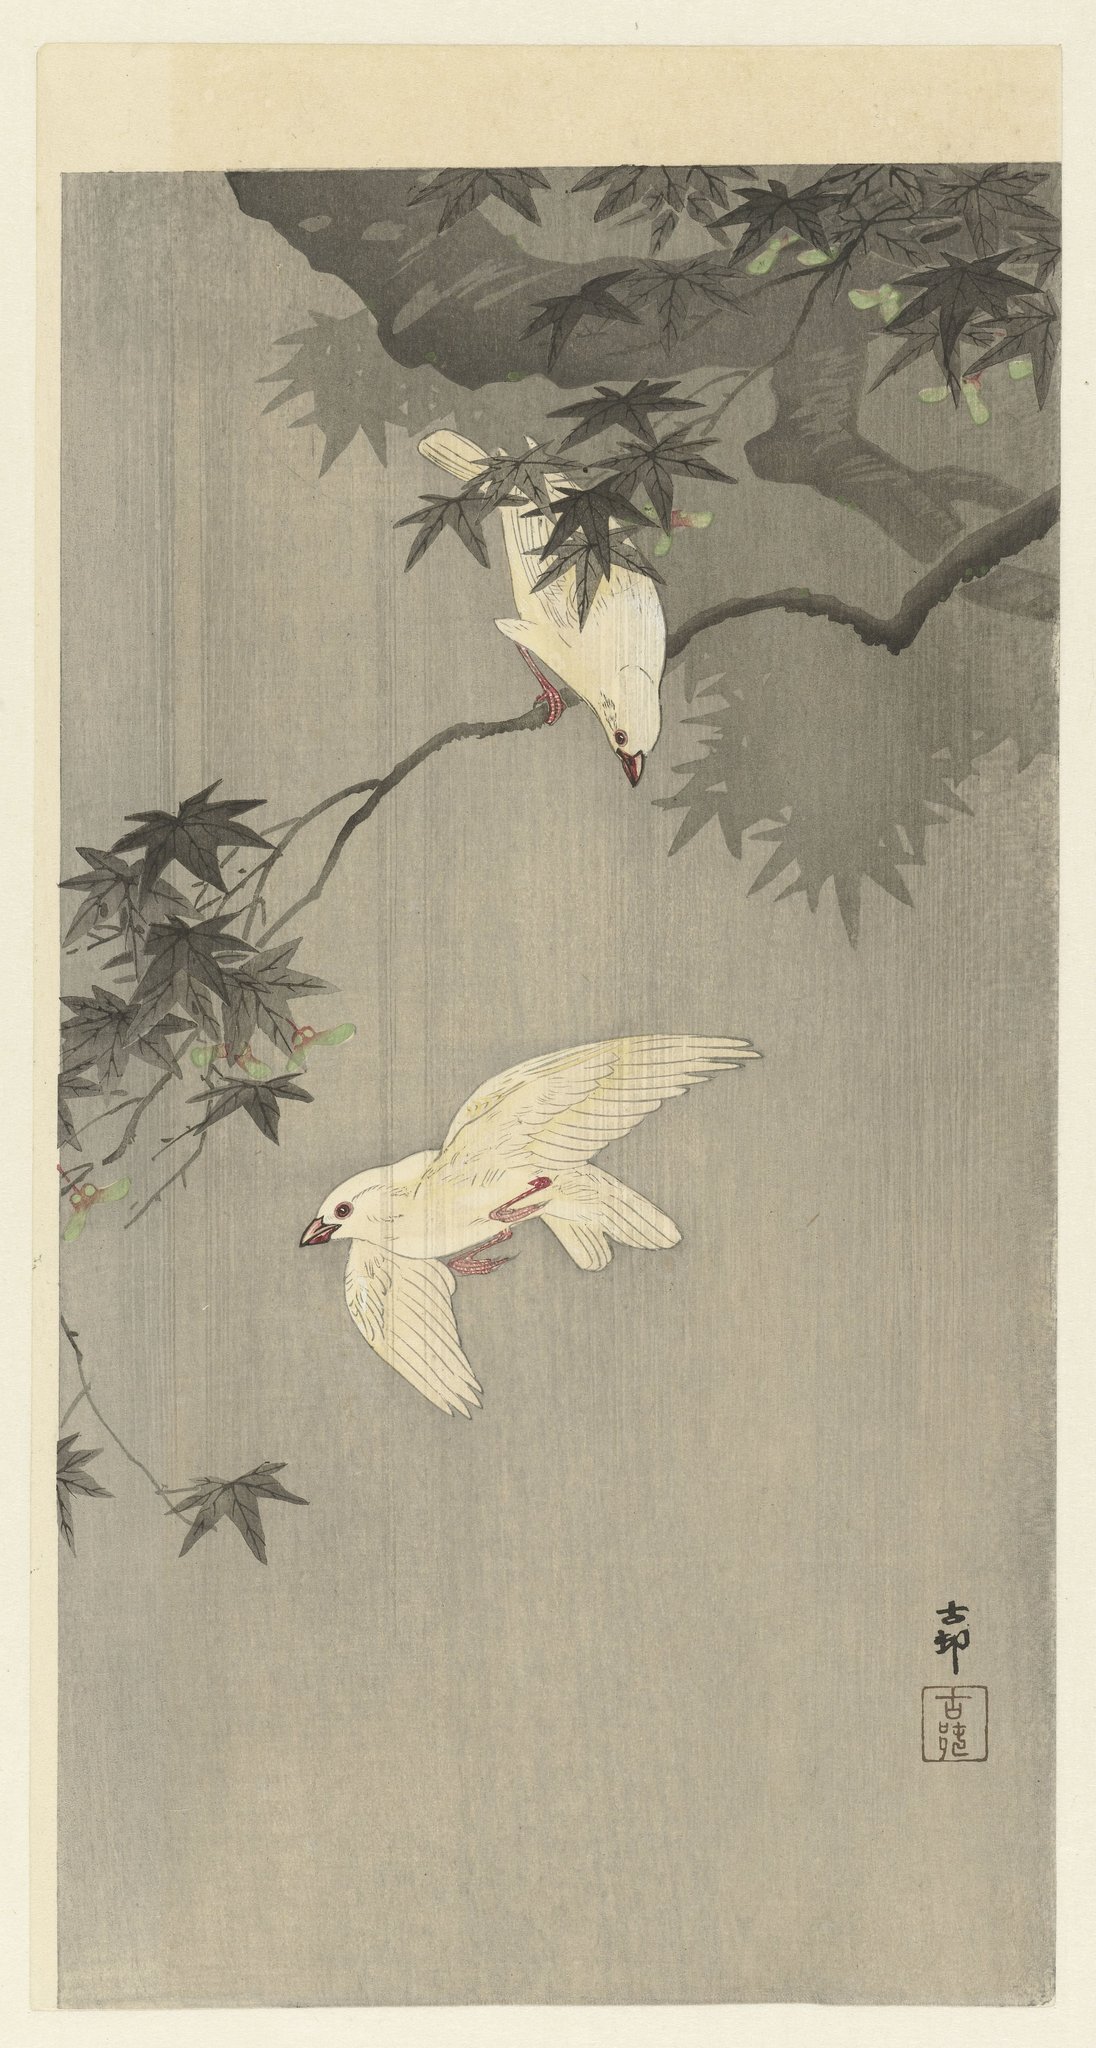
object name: print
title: Vogels in regen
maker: ohara koson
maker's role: print maker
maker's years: 1877-1945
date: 1900-1936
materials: paper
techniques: woodcut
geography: japan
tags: trees, birds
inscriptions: collector's mark: Lugt 2228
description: Twee witte vogels in de regen; de één op een tak, de ander in vlucht.